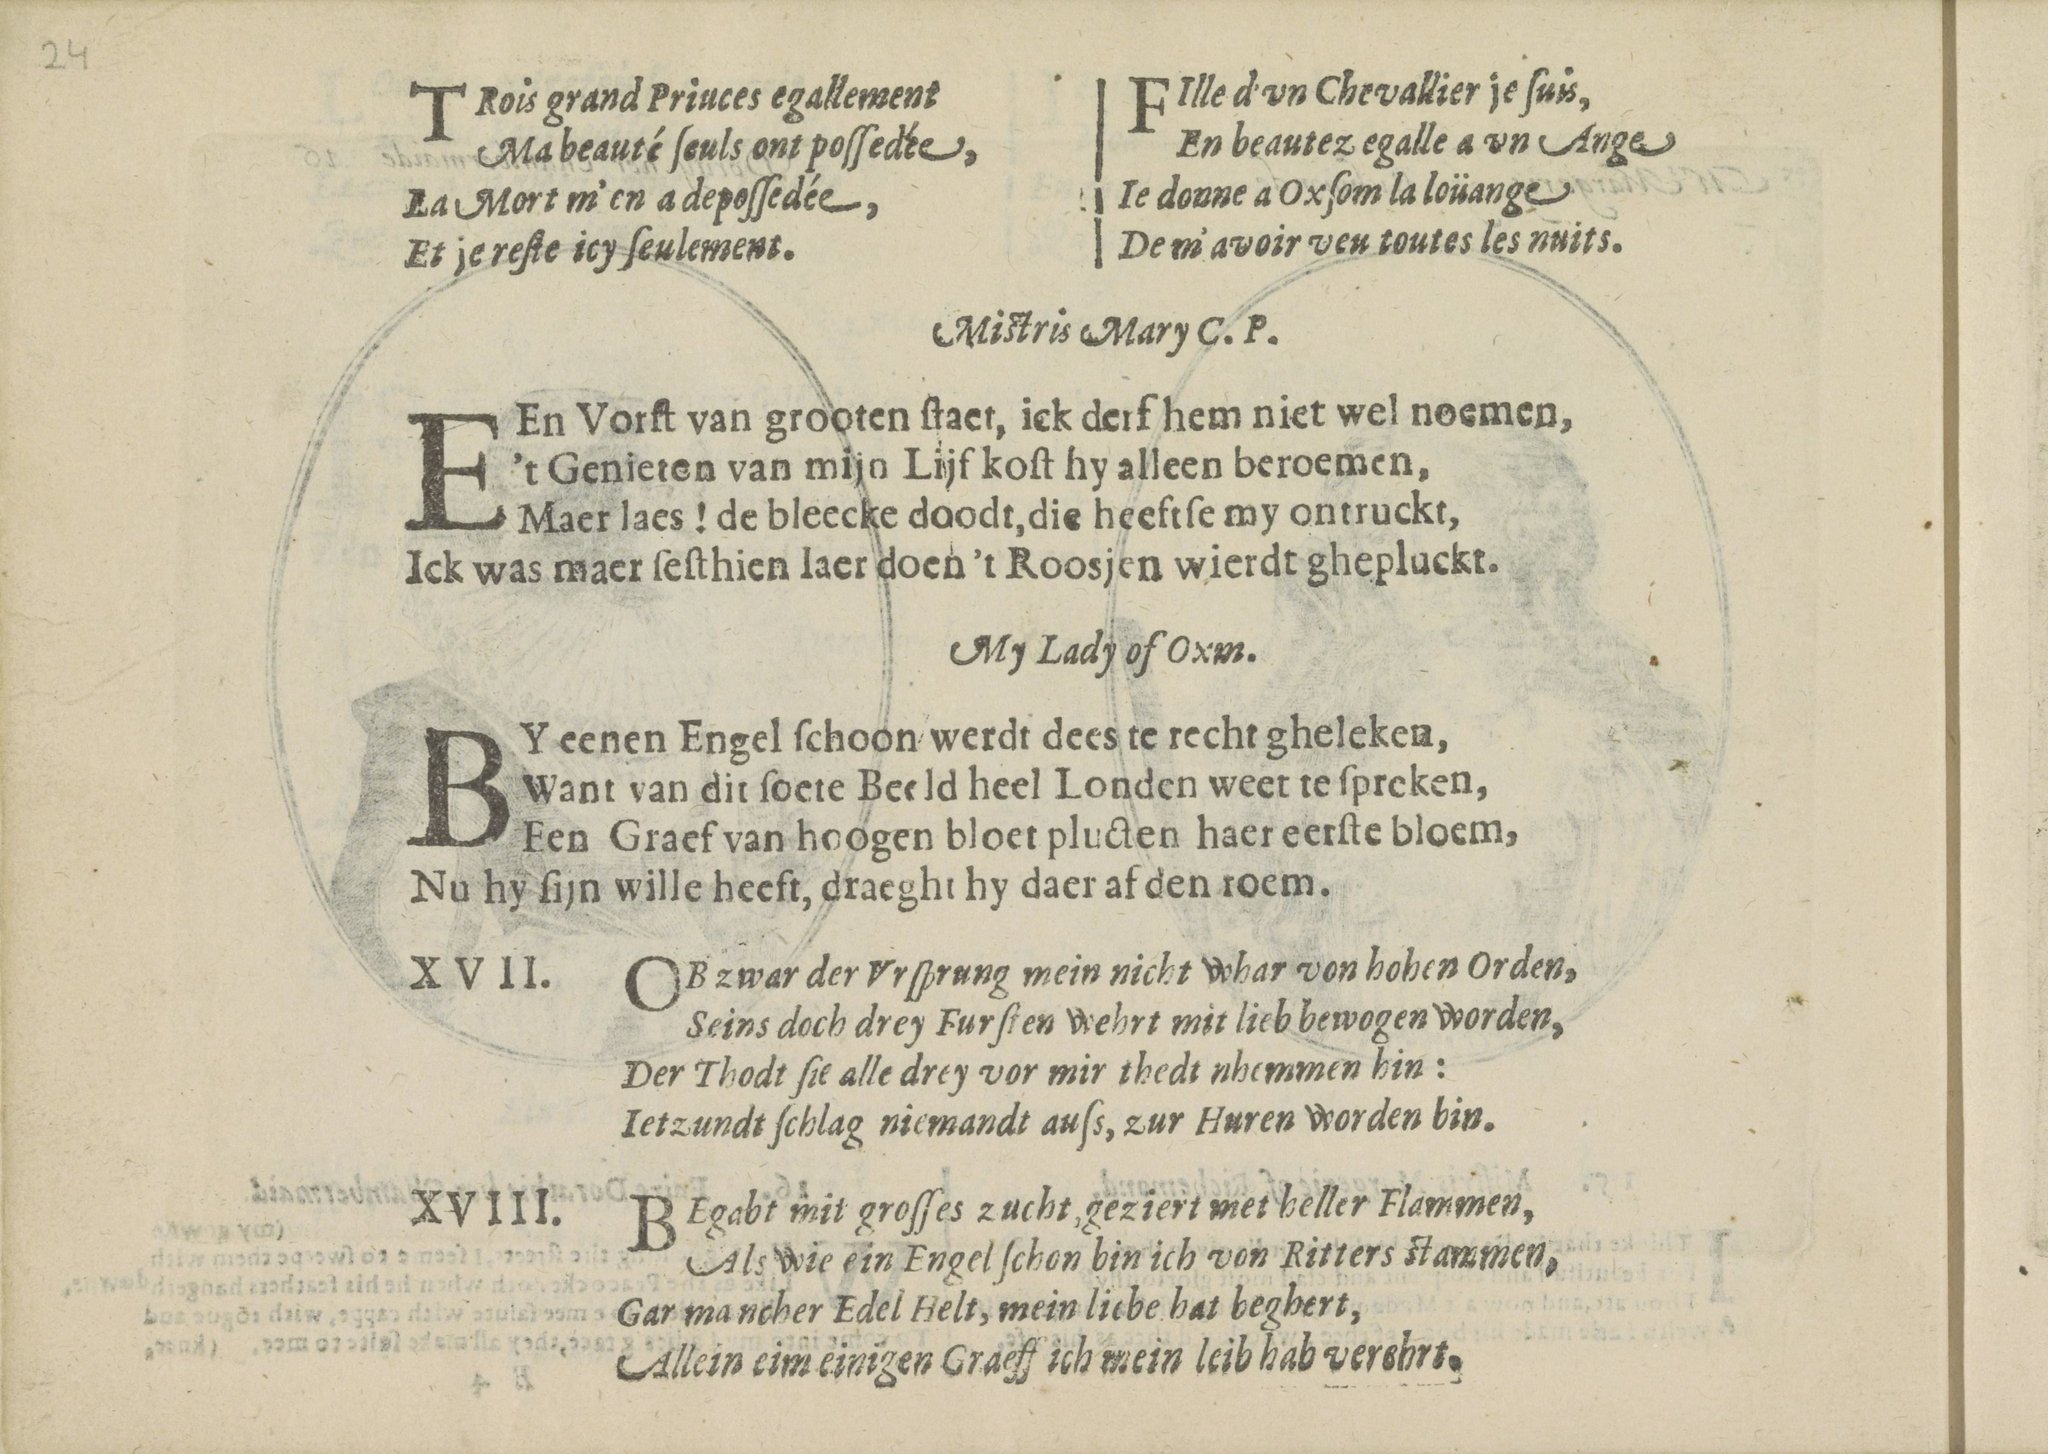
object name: text sheet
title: Miroir des plus belles courtisanes de ce temps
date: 1635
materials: paper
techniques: letterpress printing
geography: utrecht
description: Drie keer twee kwatrijnen in het Frans, Nederlands en Duits bij de portretten van de courtisanes genaamd Mistress Mary C.P. en Lady of Oxm, de laatste afkomstig uit Londen. Het blad maakt deel uit van een album.